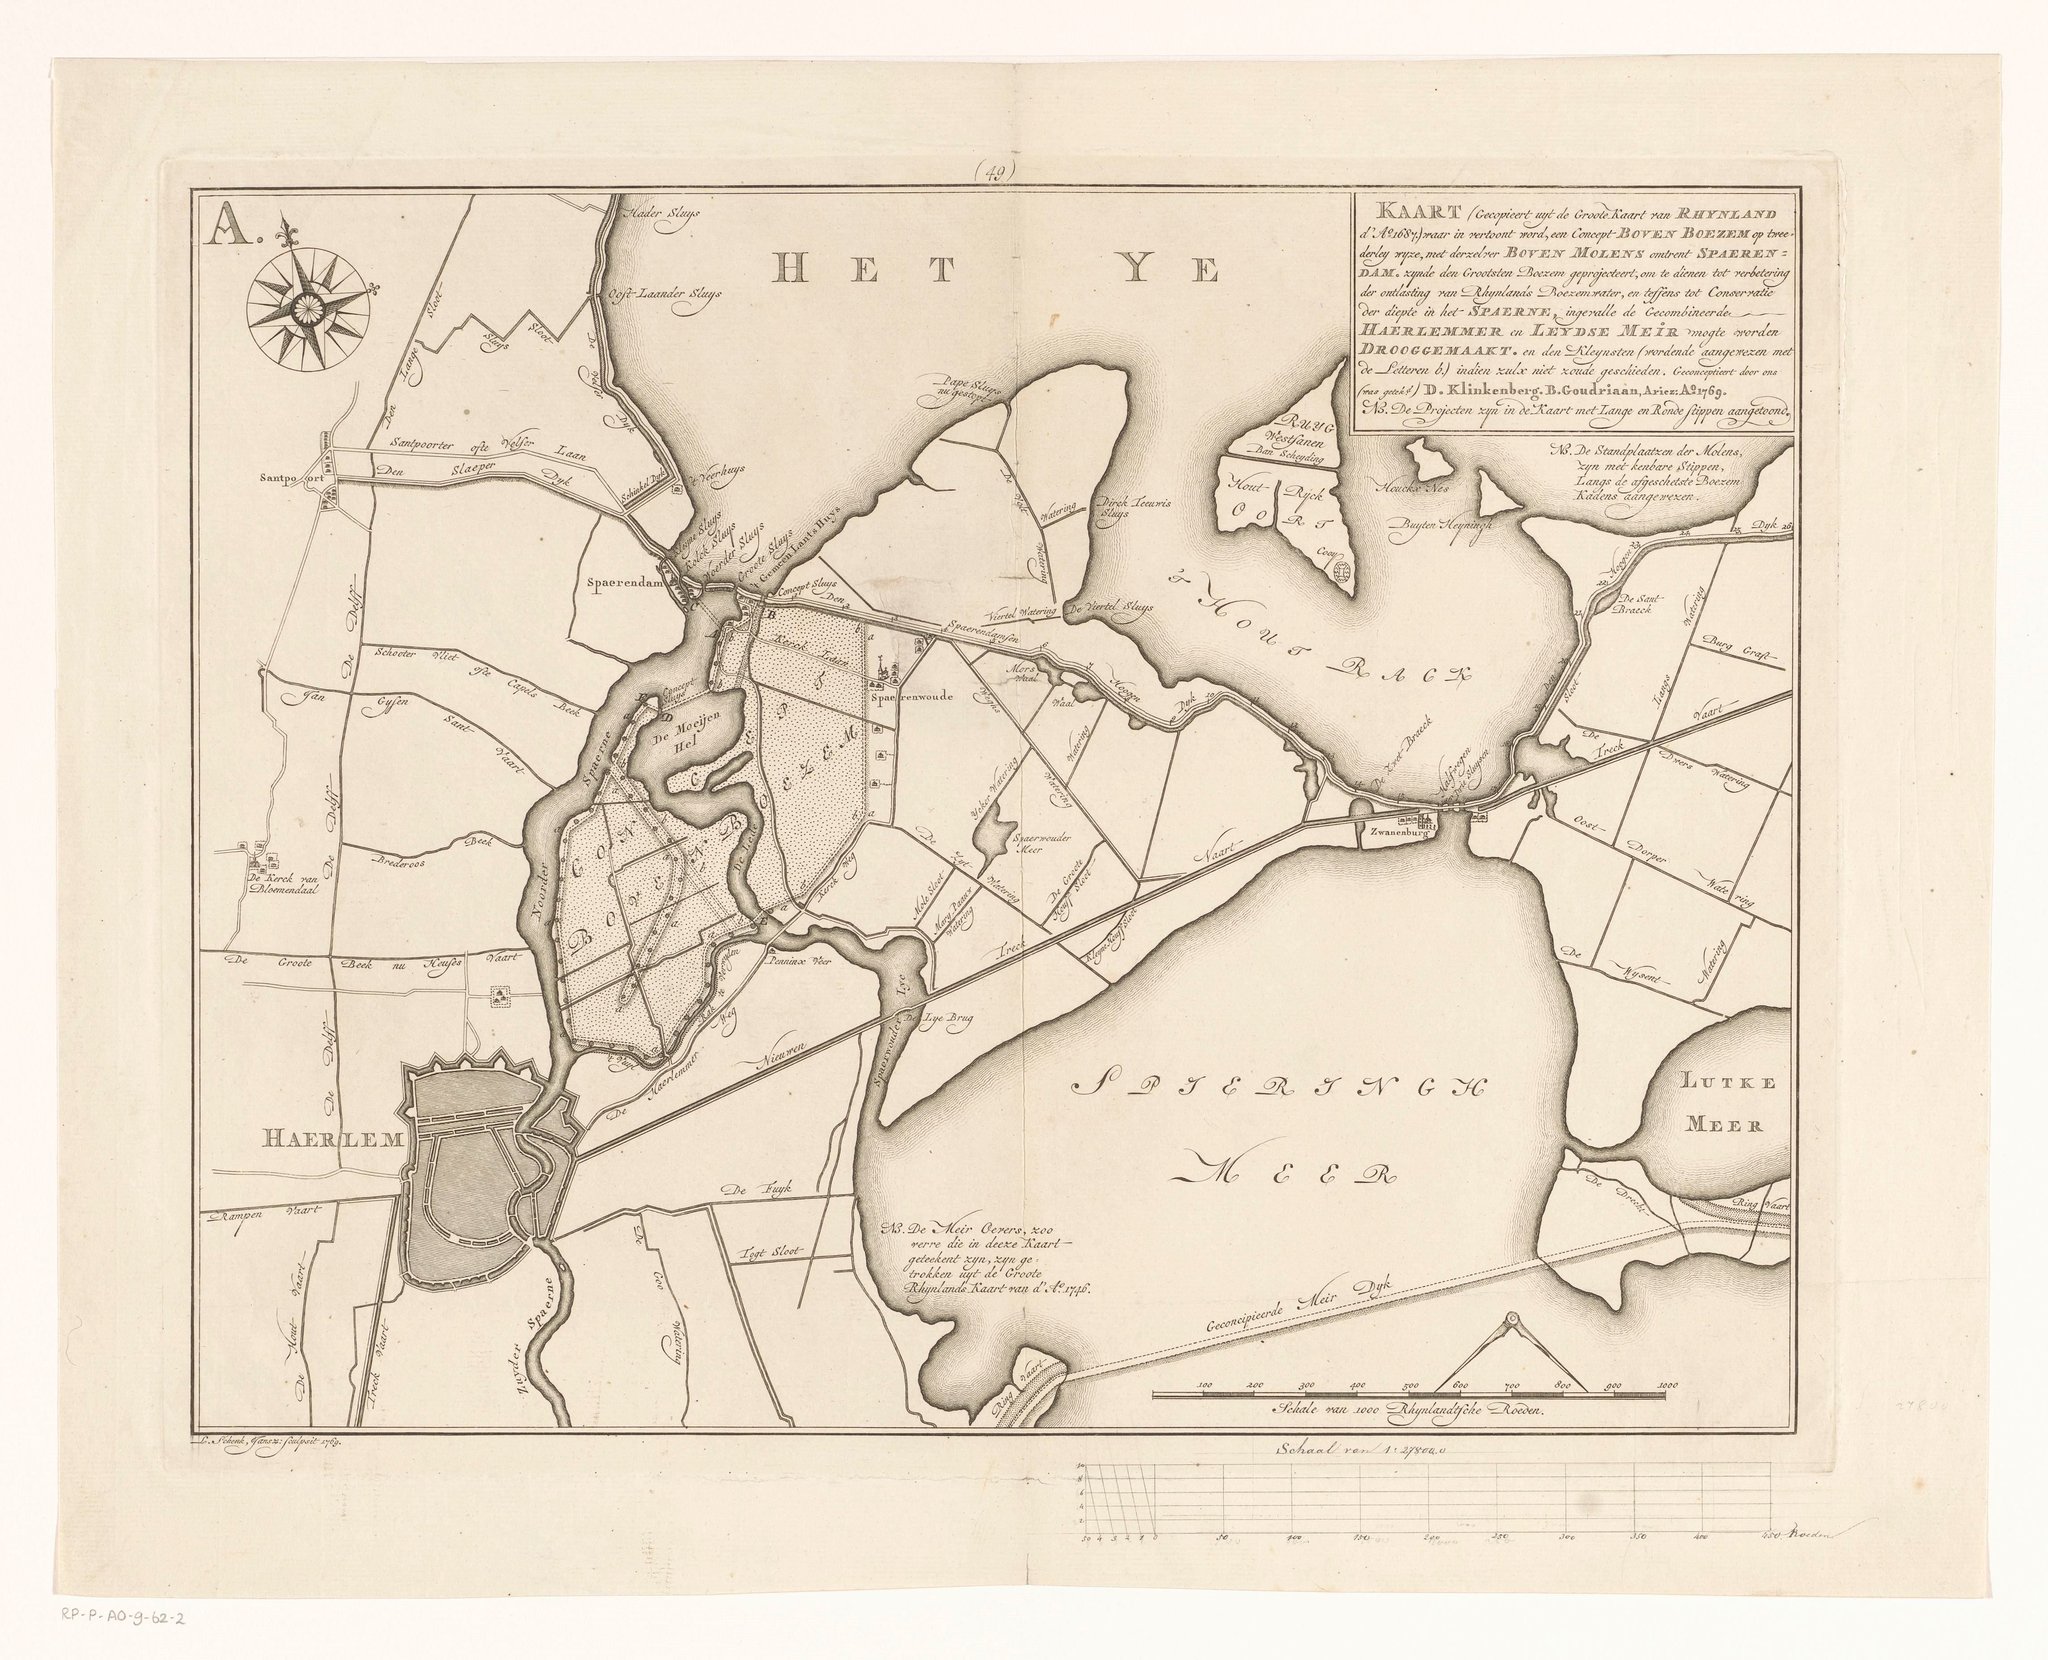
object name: map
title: Kaart met een concept bovenboezem bij Spaarndam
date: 1769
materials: ink, paper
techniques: engraving, etching, pen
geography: amsterdam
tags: maps of separate countries or regions, haarlem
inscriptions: collector's mark: Lugt 19, inscription: ‘Schaal van 1:27800.0’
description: Kaart met een concept bovenboezem (waterberging) bij Spaarndam. De kaart toont het omliggende gebied en een concept bovenboezem voor als a) het Haarlemmermeer wordt drooggelegd, b) dit niet gebeurt. Rechtsboven de titel, rechtsonder een schaalstok: Schale van 1000 Rhynlandtsche roeden.